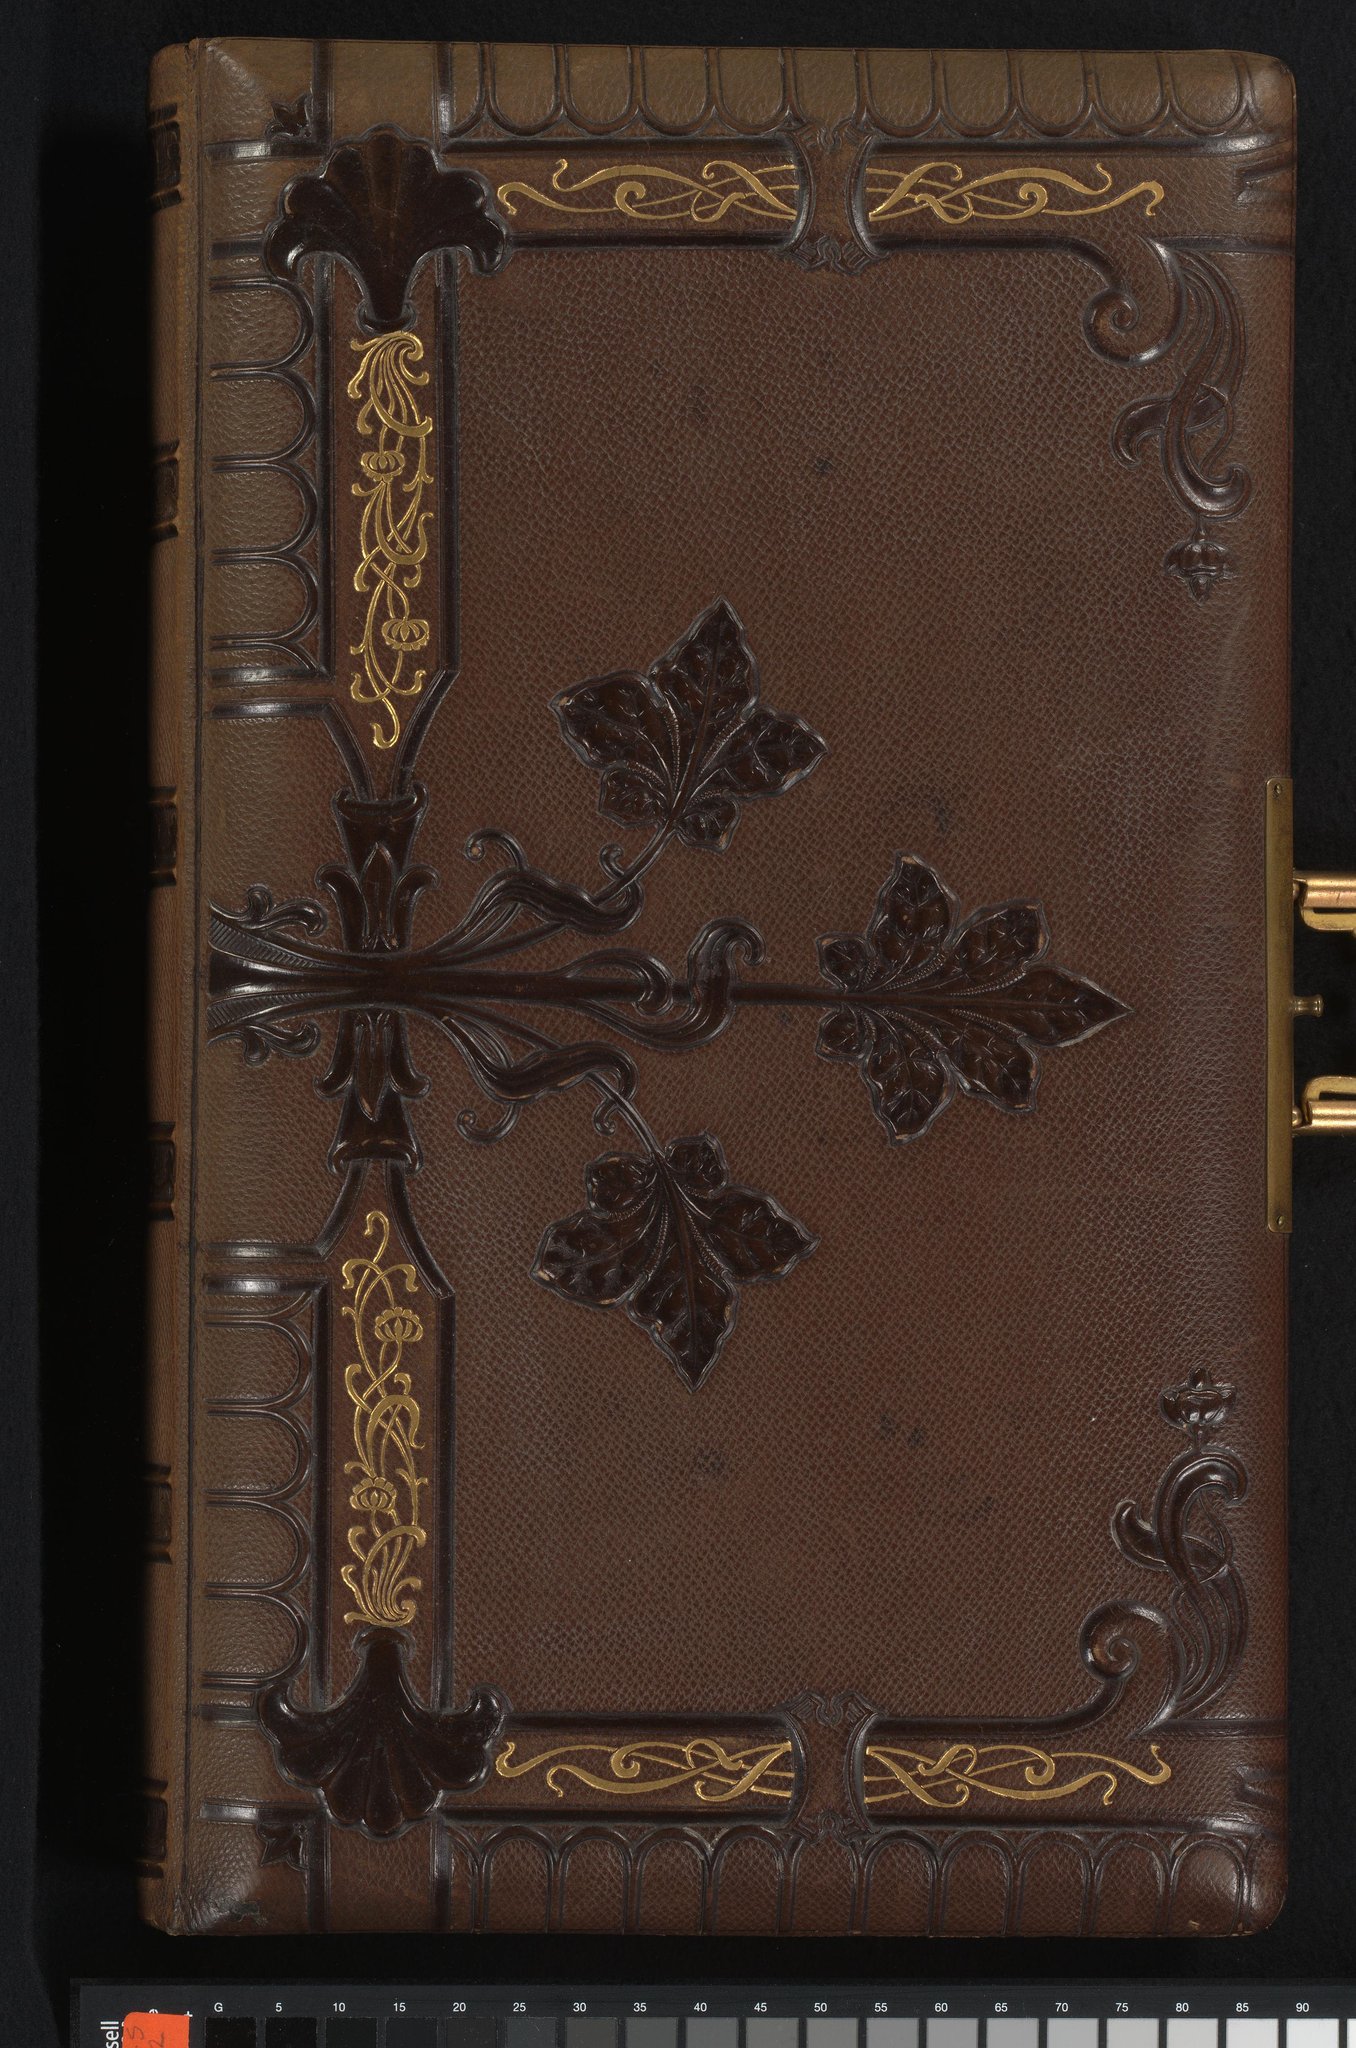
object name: slip in album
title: Nederlands familiealbum met 86 foto's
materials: cardboard, leather, metal, paper, photographic support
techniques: albumen print, decorated paper, gelatin silver print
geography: groningen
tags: historical persons - bb - woman, child, historical persons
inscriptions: dedication: ‘Aan onze logé, die ons in twee/ Eeuwen gezelschap hield, ter herinnering/ aan de familie van Campen./ Goes, 23 Januari 1901.’, collector's mark: ‘DIENST/ VERSPREIDE/ RIJKSKOLLEKTIES/ (...) A 984’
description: Fotoalbum met 30 pagina's met in totaal 86 foto's. Het album bevat 61 cartes-de-visite, 20 kabinetfoto's, 4 prentbriefkaarten en een foto op karton van afwijkend formaat. Een kabinetfoto en de foto van afwijkend formaat bevinden zich los achterin het album, de overige foto's zijn in met gouden lijnen omkaderde passe-partouts gestoken. Niet alle passe-partouts in het album zijn gevuld. Afgebeeld zijn portretten van mannen, vrouwen en kinderen, waarvan 5 bij naam bekend zijn. De foto's zijn gemaakt door hoofdzakelijk Nederlandse fotografen, waarvan 25 gemaakt zijn door Friedrich Julius von Kolkow. Van 4 foto's is de fotograaf anoniem.